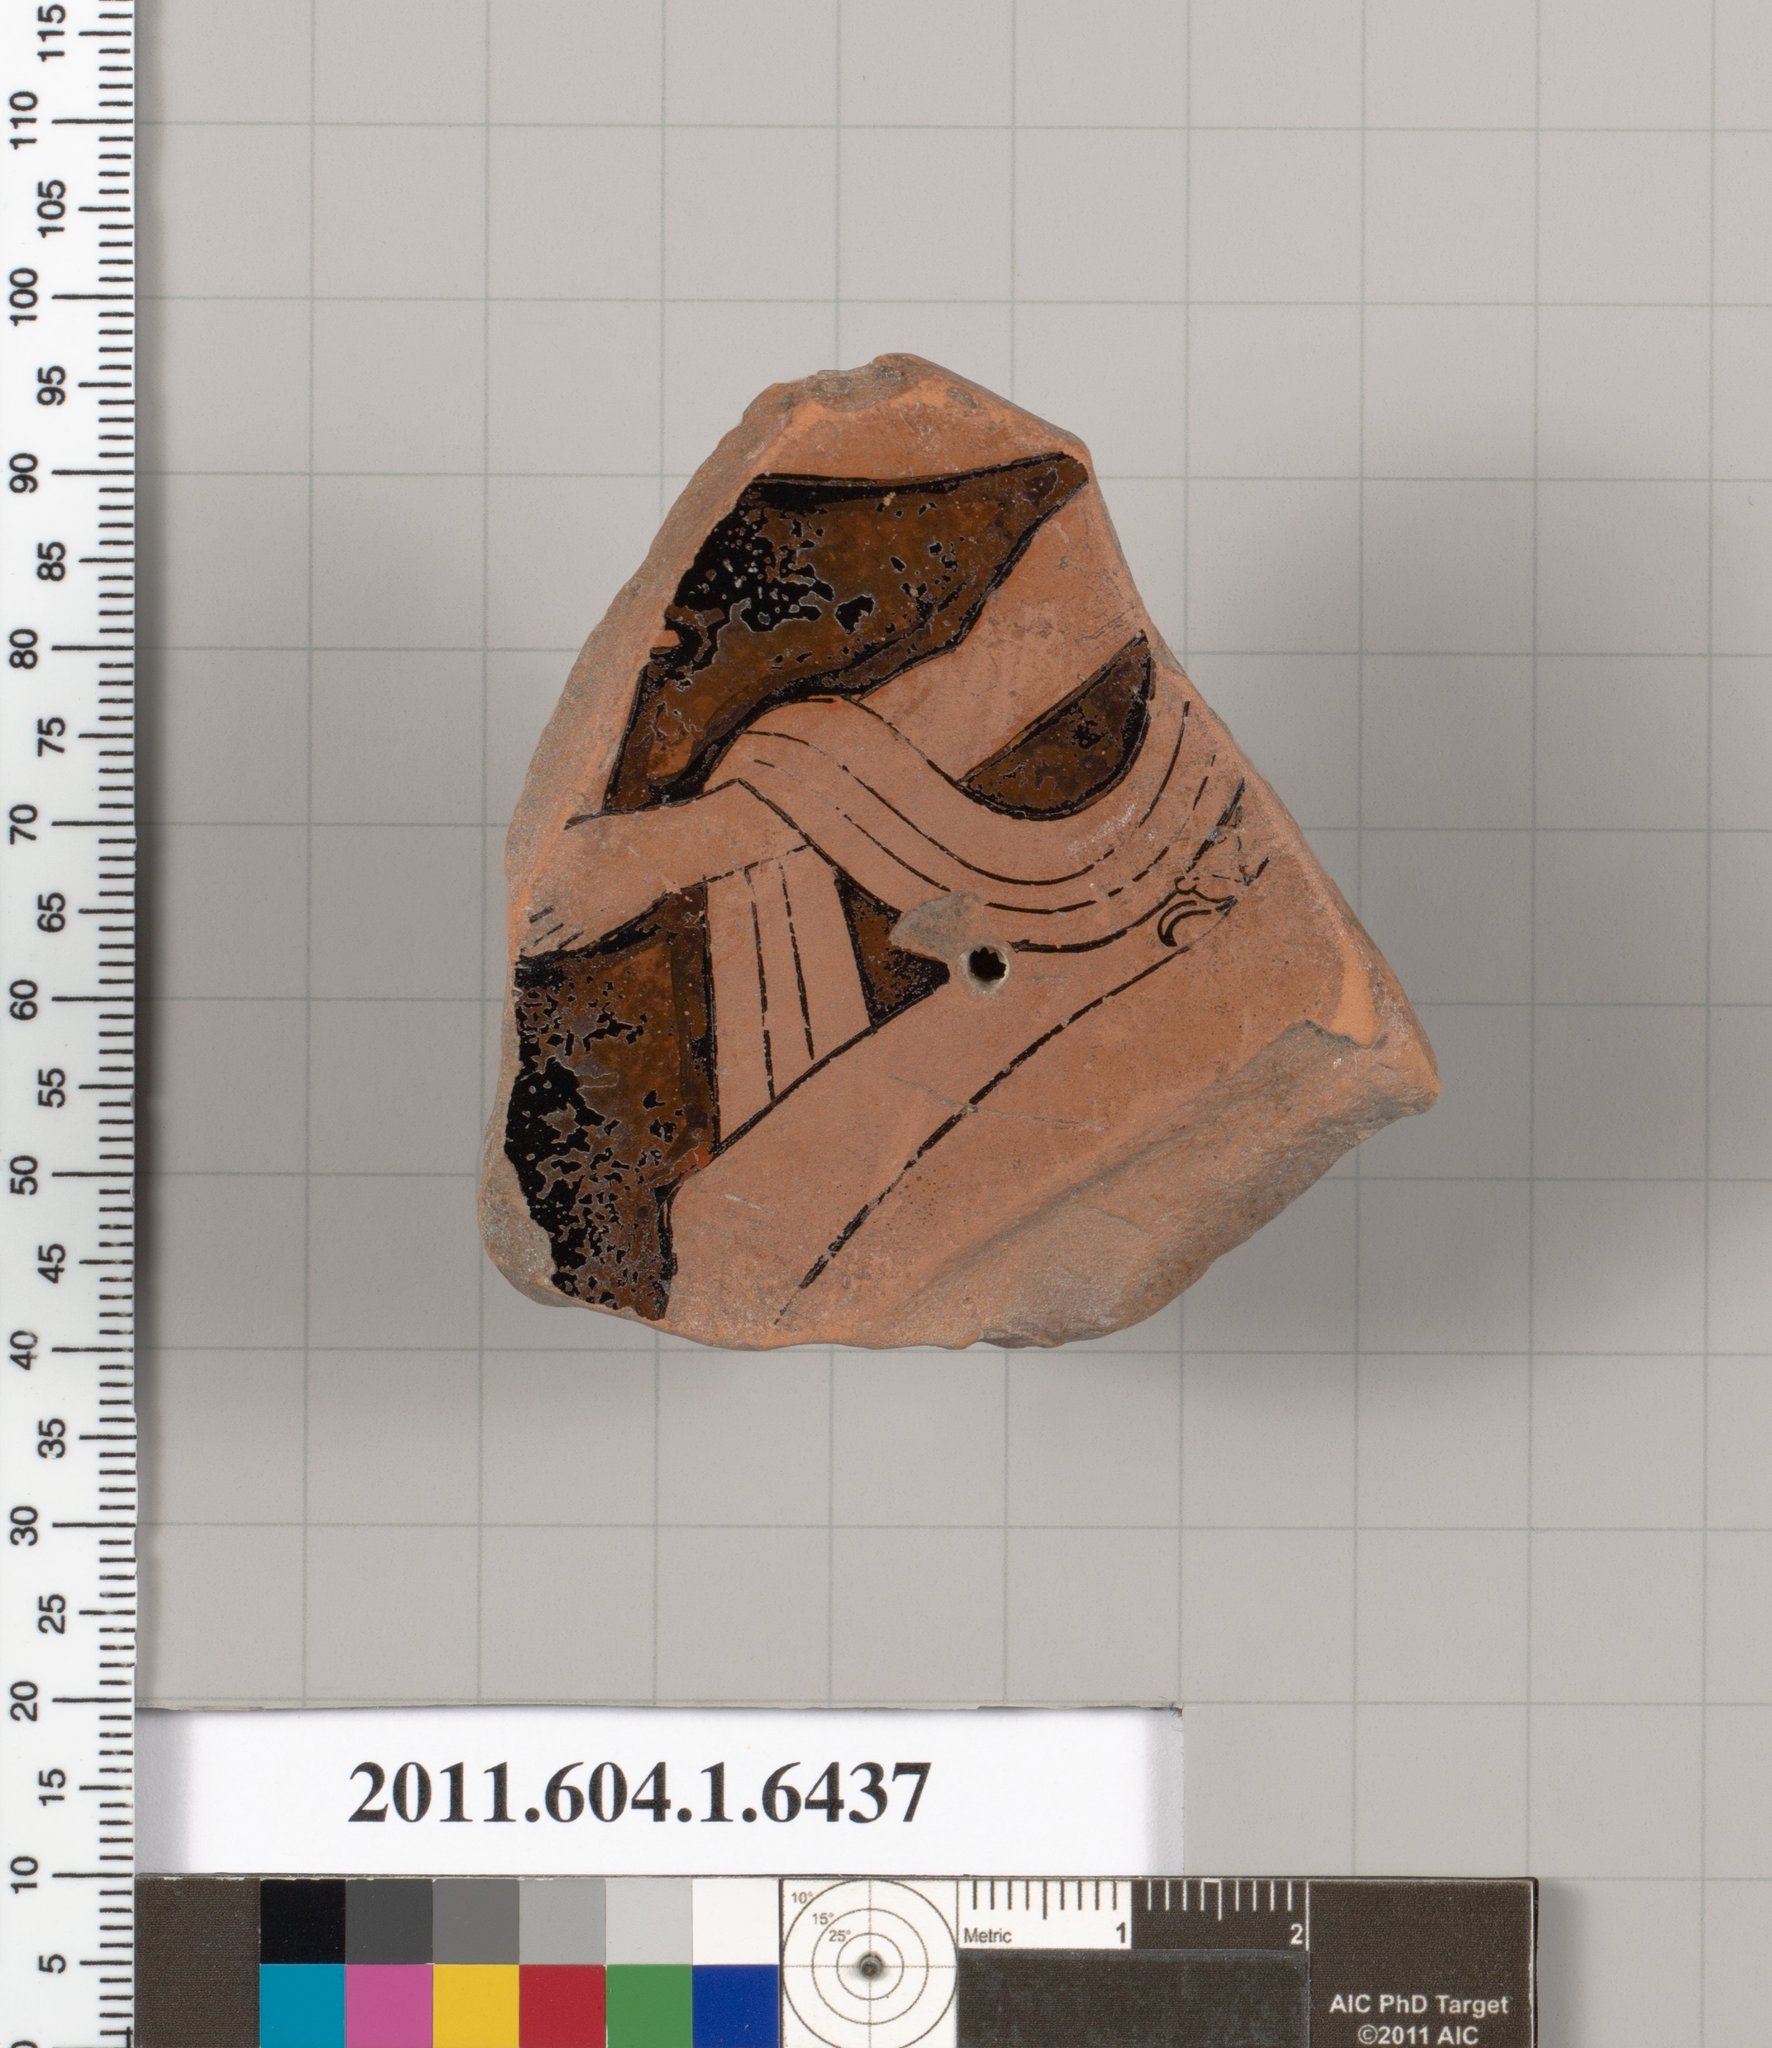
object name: kylix fragment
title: Terracotta fragment of a kylix (drinking cup)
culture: greek, attic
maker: antiphon painter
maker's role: artist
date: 490-480 BCE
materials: terracotta